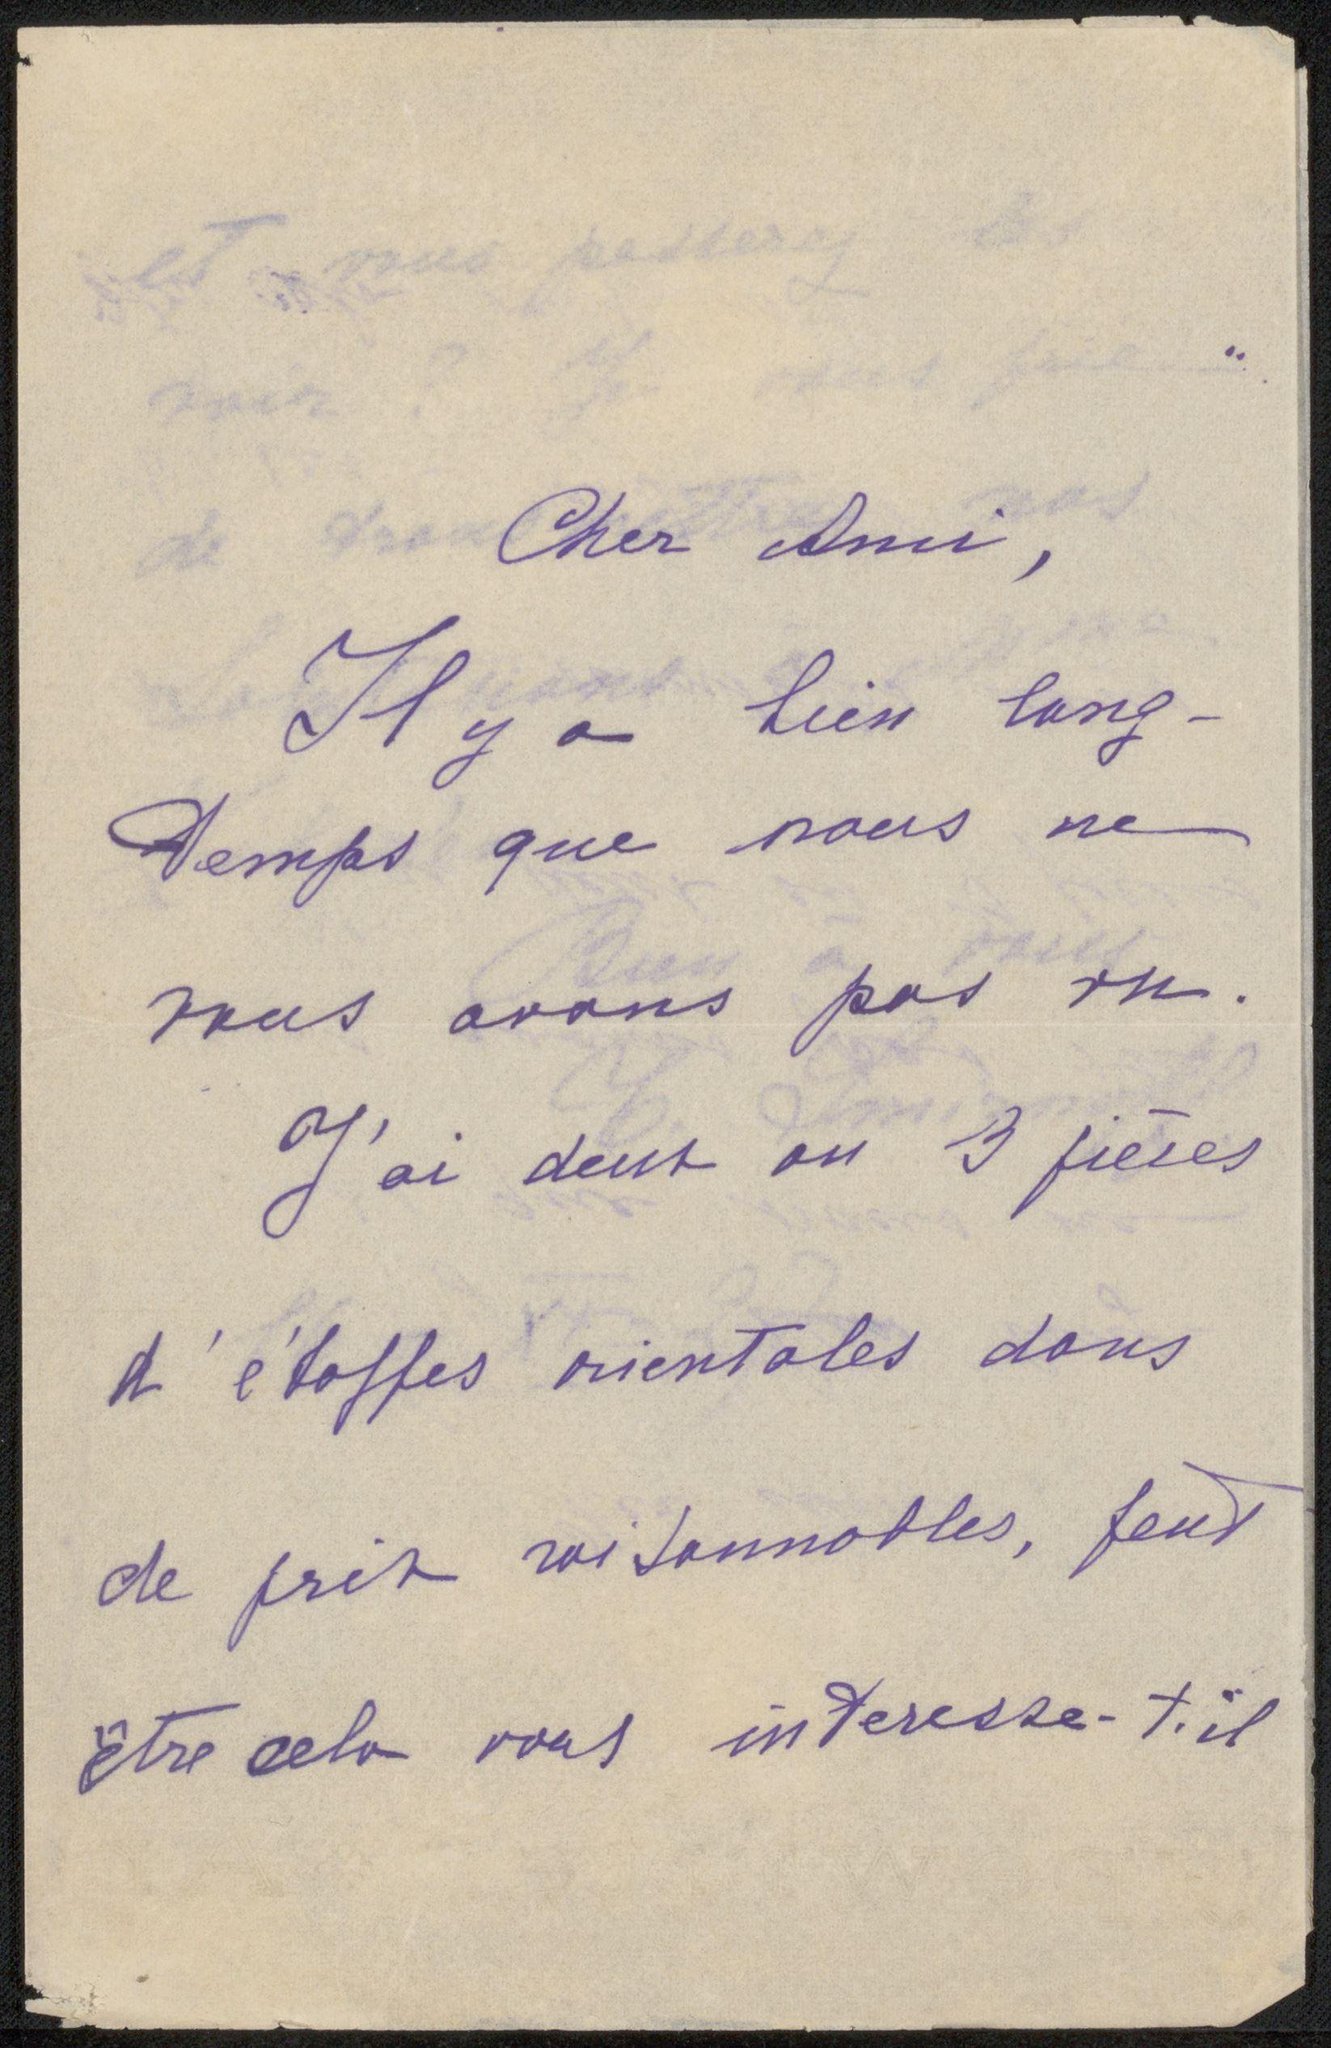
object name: letter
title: Brief aan Philip Zilcken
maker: t. smirnoff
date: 1927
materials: ink, paper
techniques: pen, writing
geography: nice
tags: the hague, painter, draughtsman, philip zilcken, applied arts, arts and crafts; industrial design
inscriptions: collector's mark: ‘RPK’